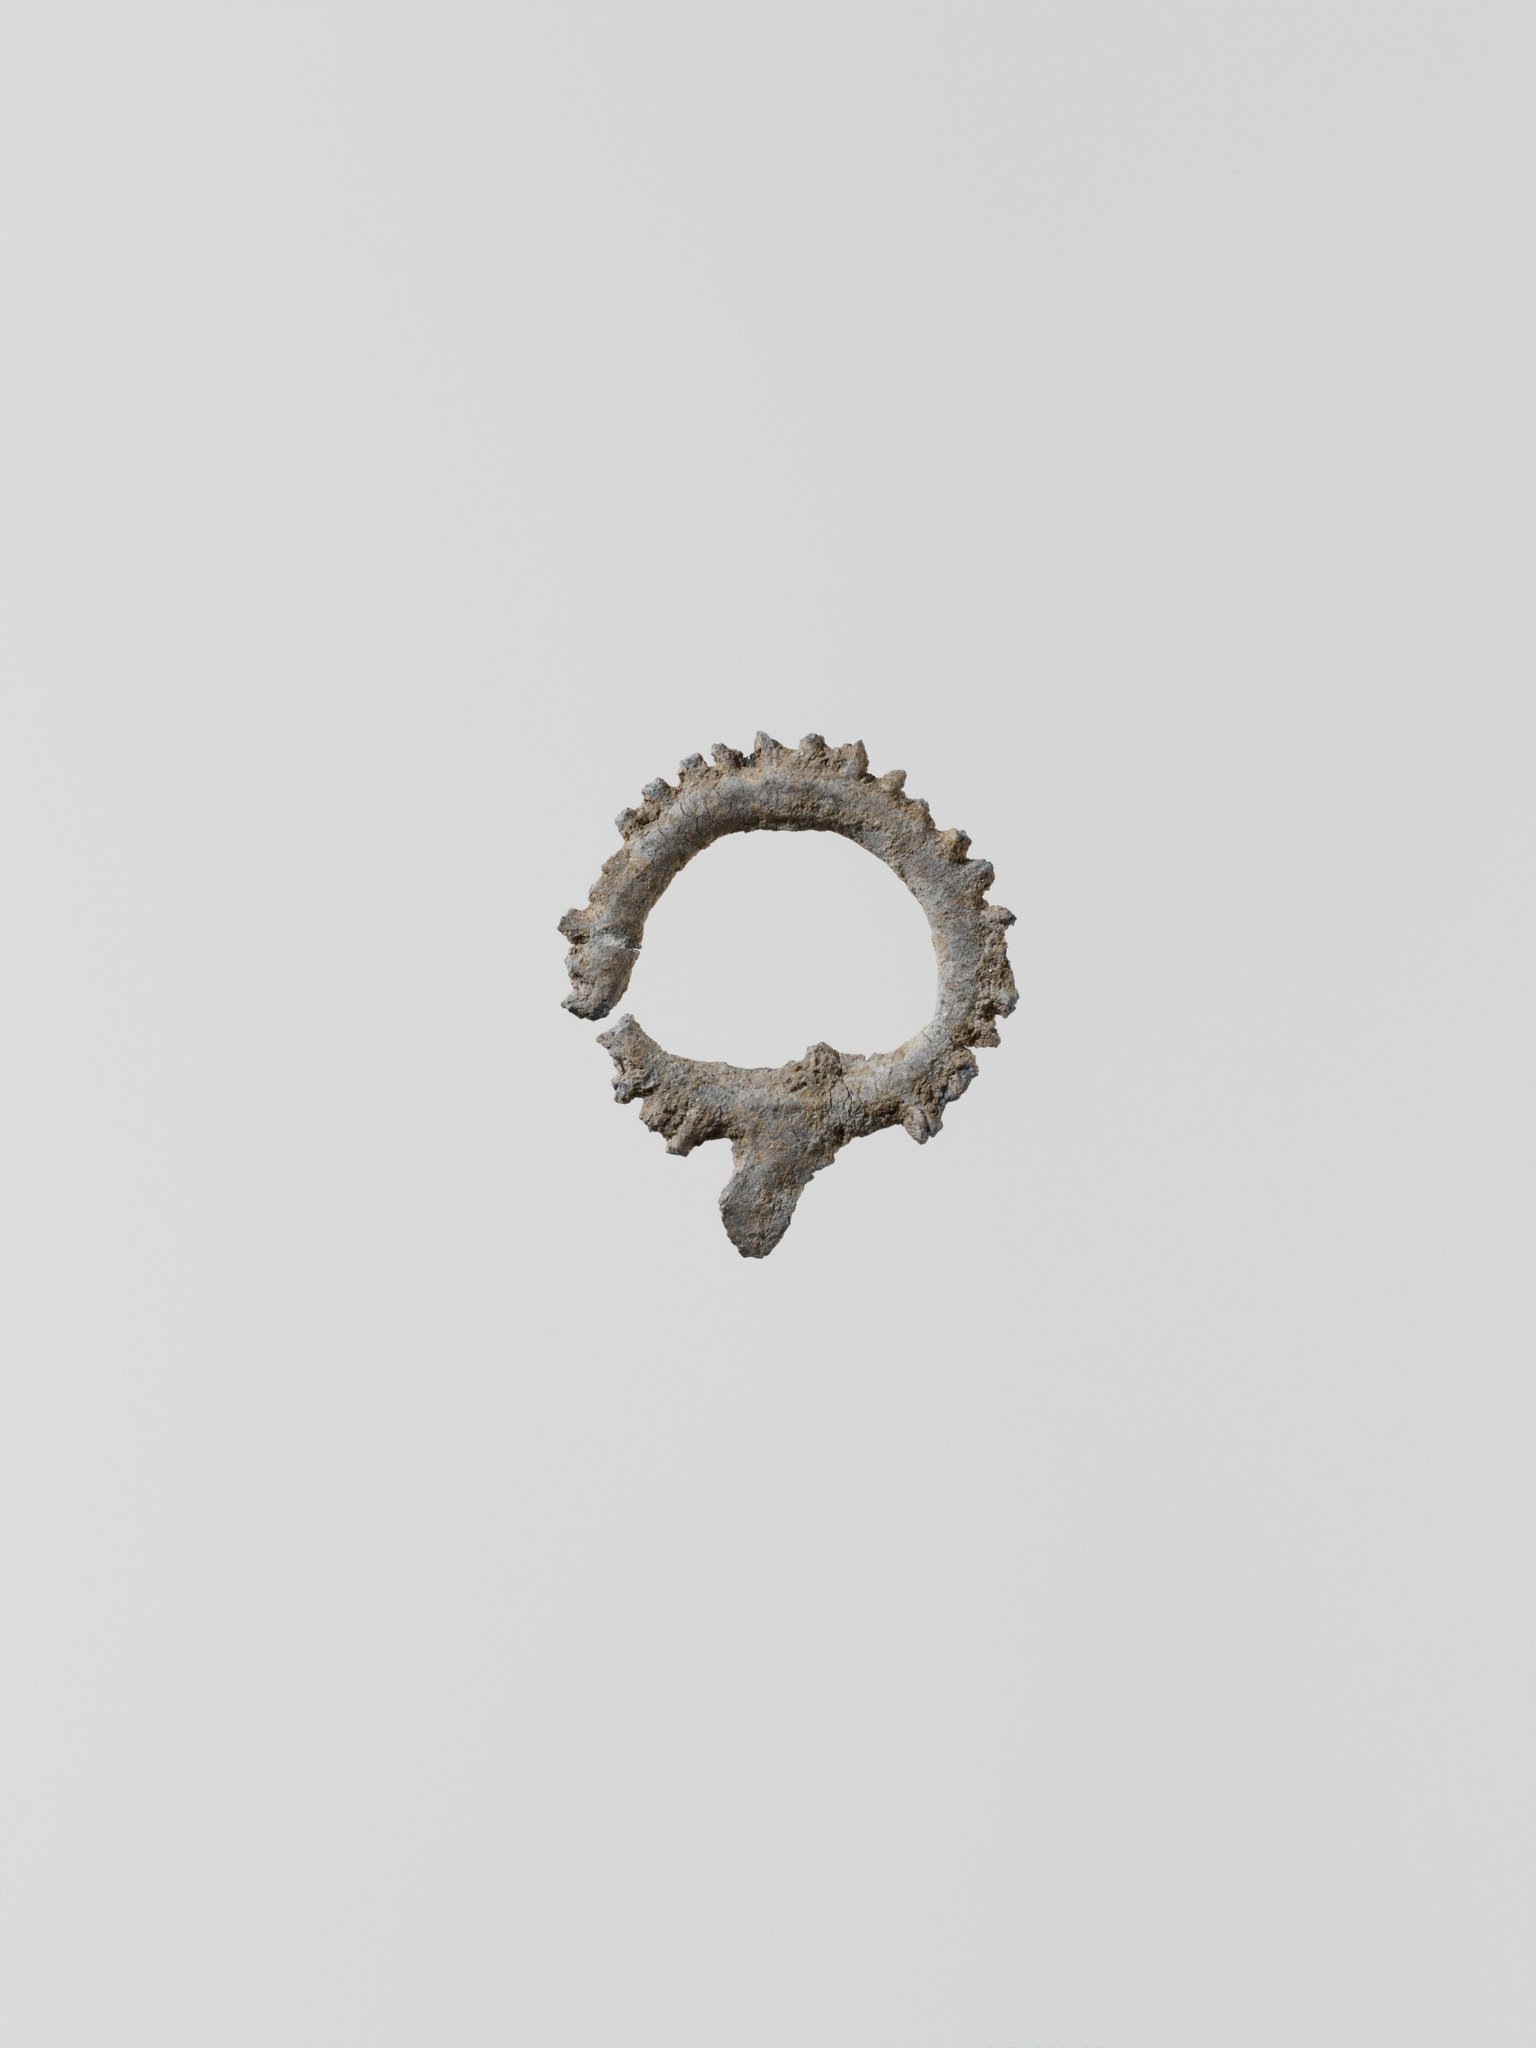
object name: wreath, 11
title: Wreaths, 11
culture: greek, laconian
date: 7000-30 BCE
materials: lead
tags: wreaths